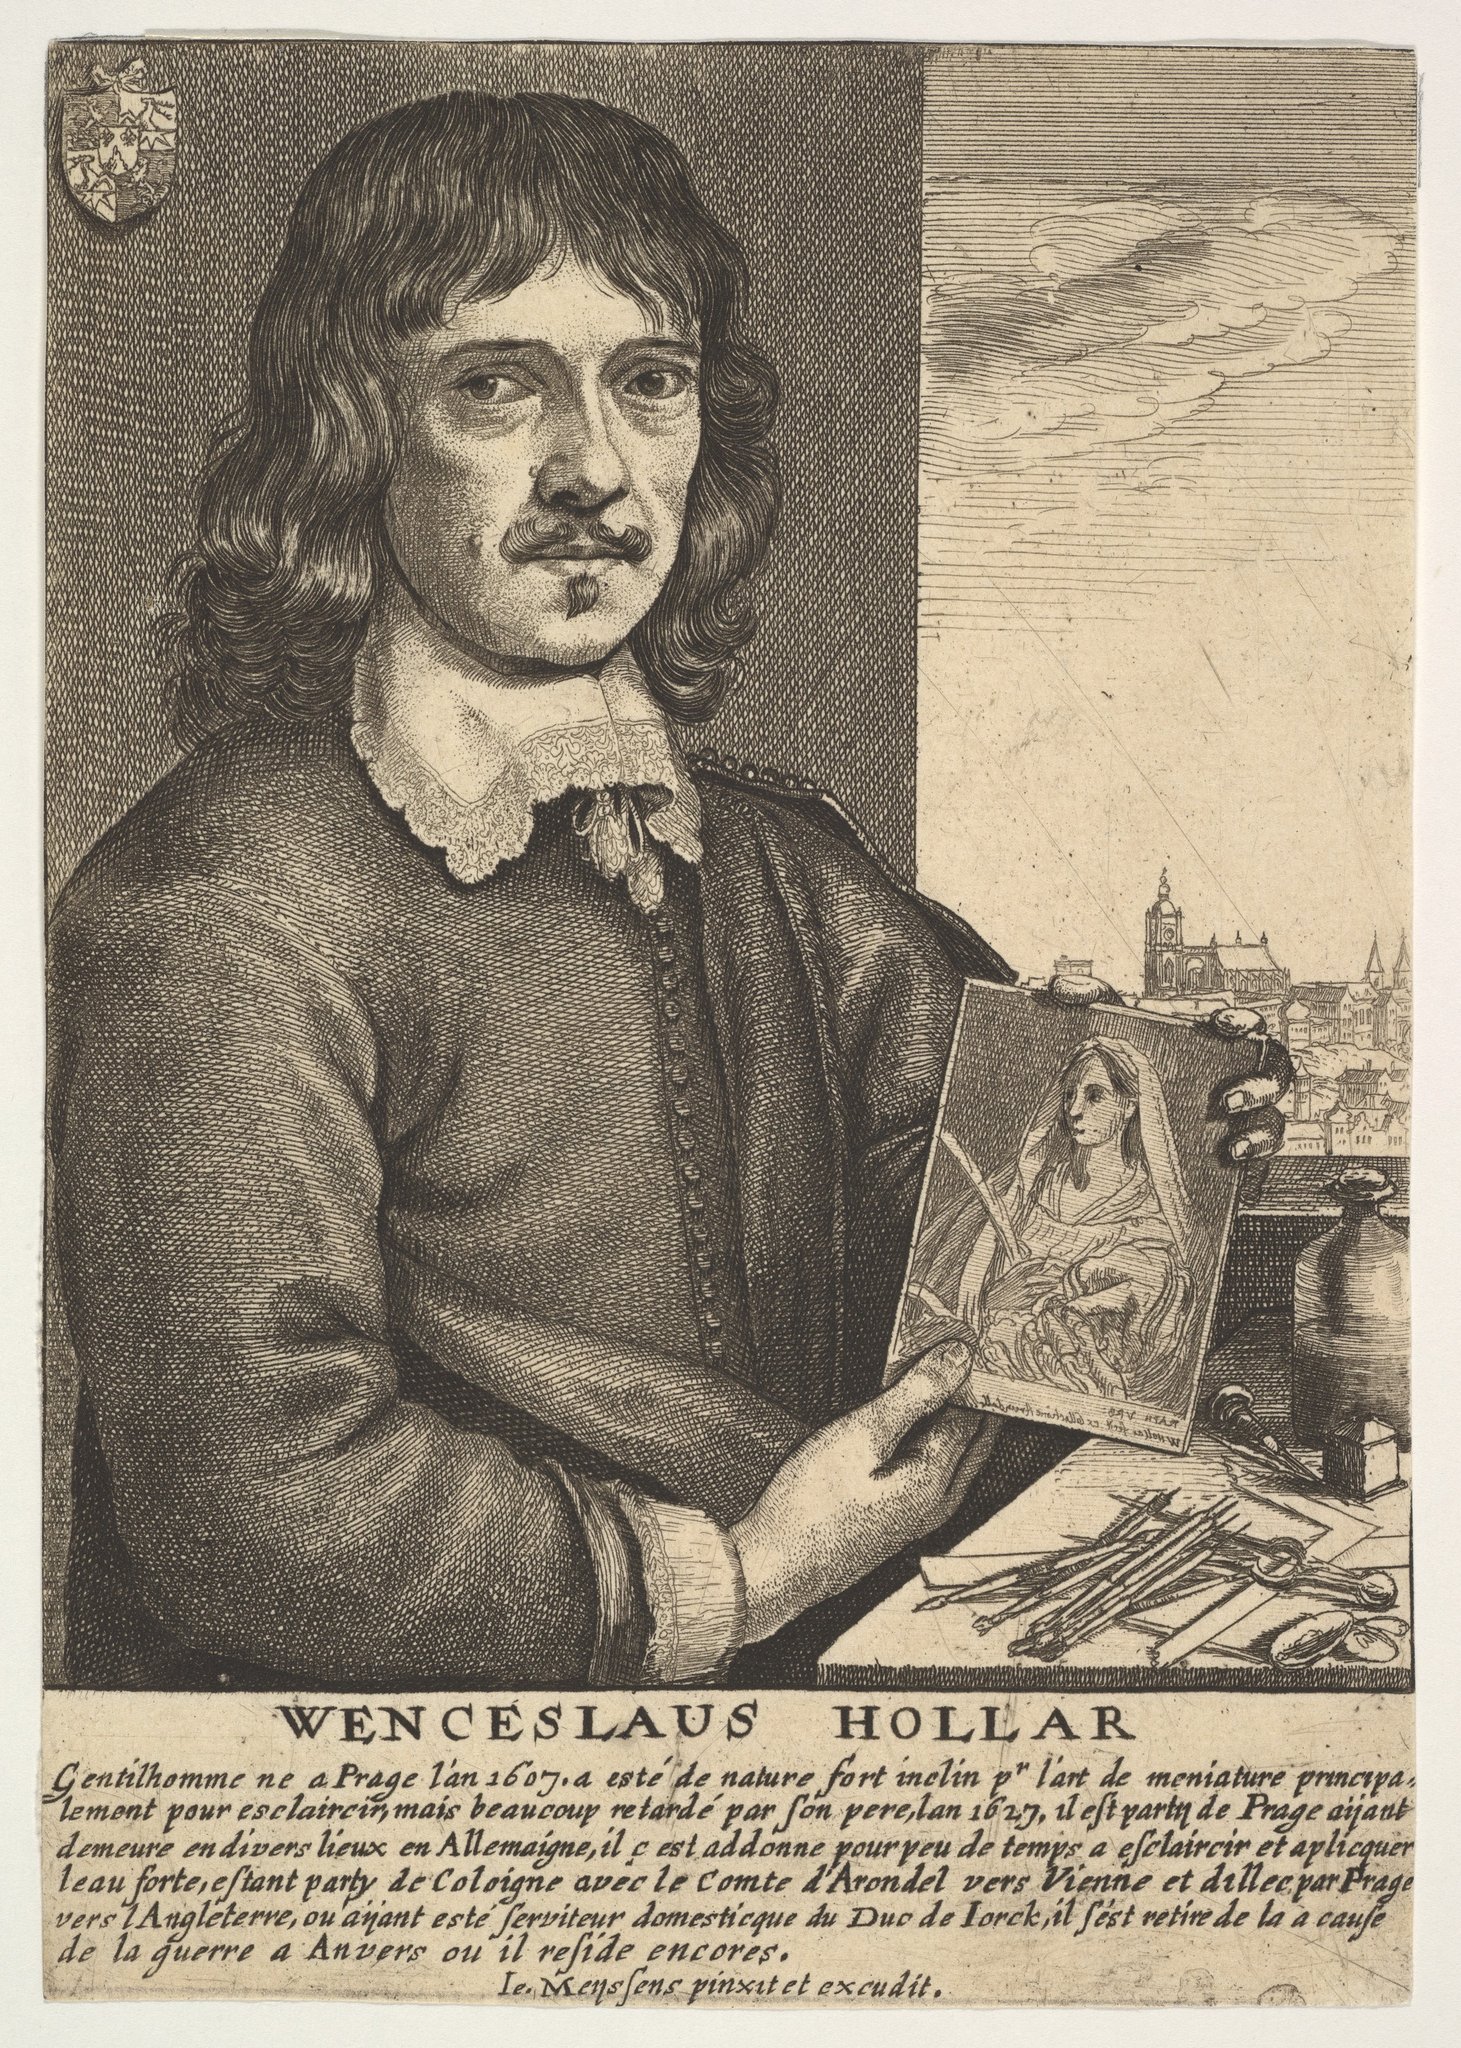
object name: print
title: Self-Portrait, from "Image de divers hommes: The true effigies of the most eminent Painters"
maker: wenceslaus hollar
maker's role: artist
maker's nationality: bohemian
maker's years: 1607-1677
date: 1601-1700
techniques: etching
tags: men,self-portraits,women